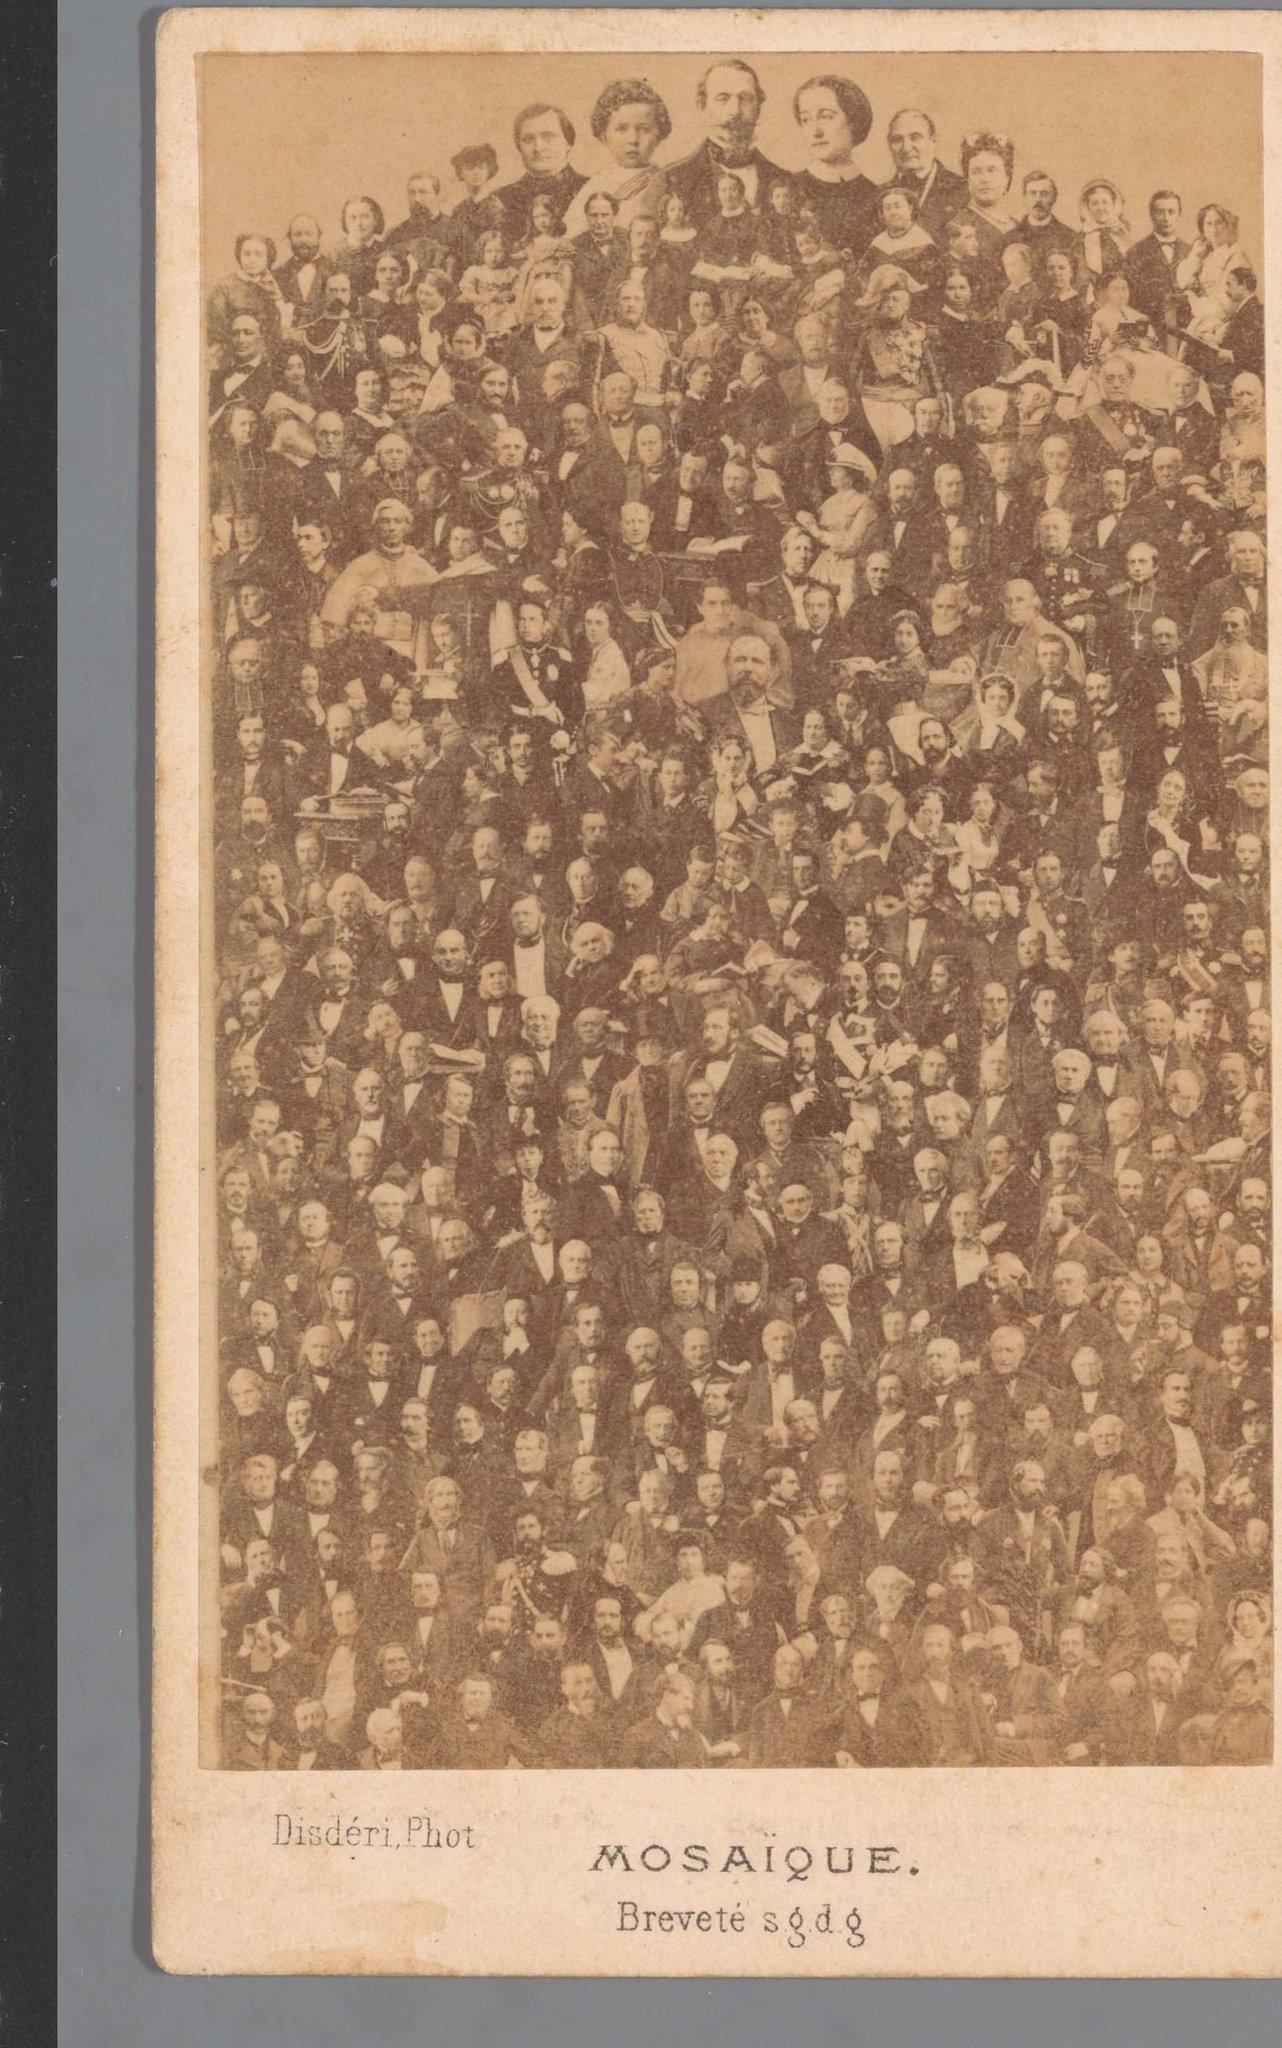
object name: photograph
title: Mosaïque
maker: andré-adolphe-eugène disdéri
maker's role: fotograaf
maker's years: 1819-1889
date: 1850-1889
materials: cardboard, photographic support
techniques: albumen print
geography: paris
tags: paris, london, napoleon iii (keizer der fransen), brussels, willem iii (koning der nederlanden), historical persons - bb - woman, historical persons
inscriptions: inscription: ‘Breveté s.g.d.g.’, number: ‘12€’, address: ‘DISDÉRI/ PHOTOGRAPHE DE S.M. L'EMPEREUR/ 8, Boulevard des Italiens/ PARIS’